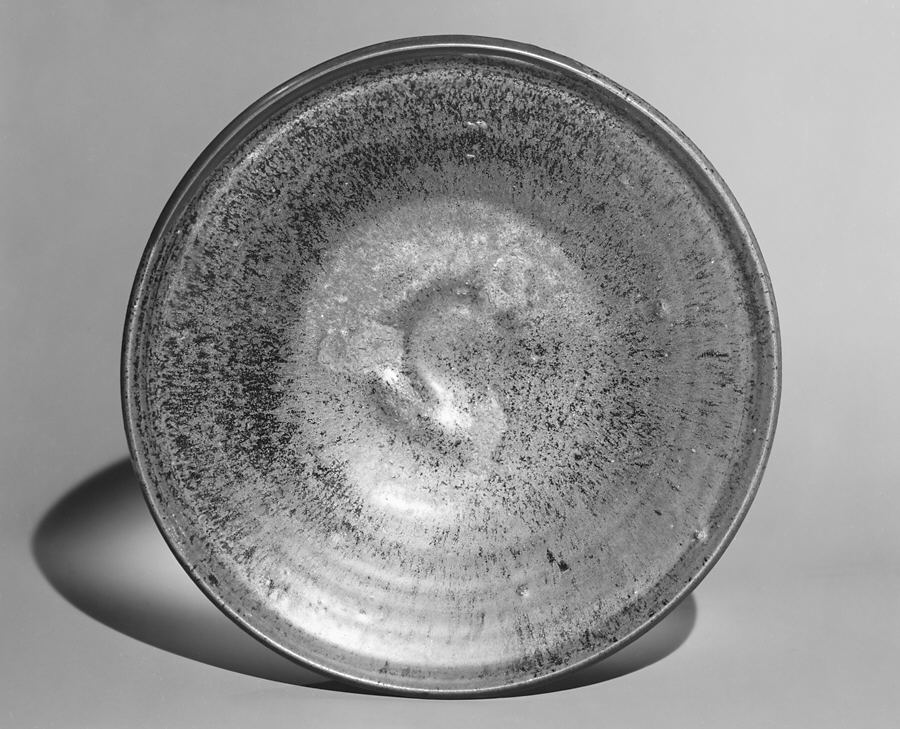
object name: dish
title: Shallow Dish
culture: japanese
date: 1573-1615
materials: glaze, iron